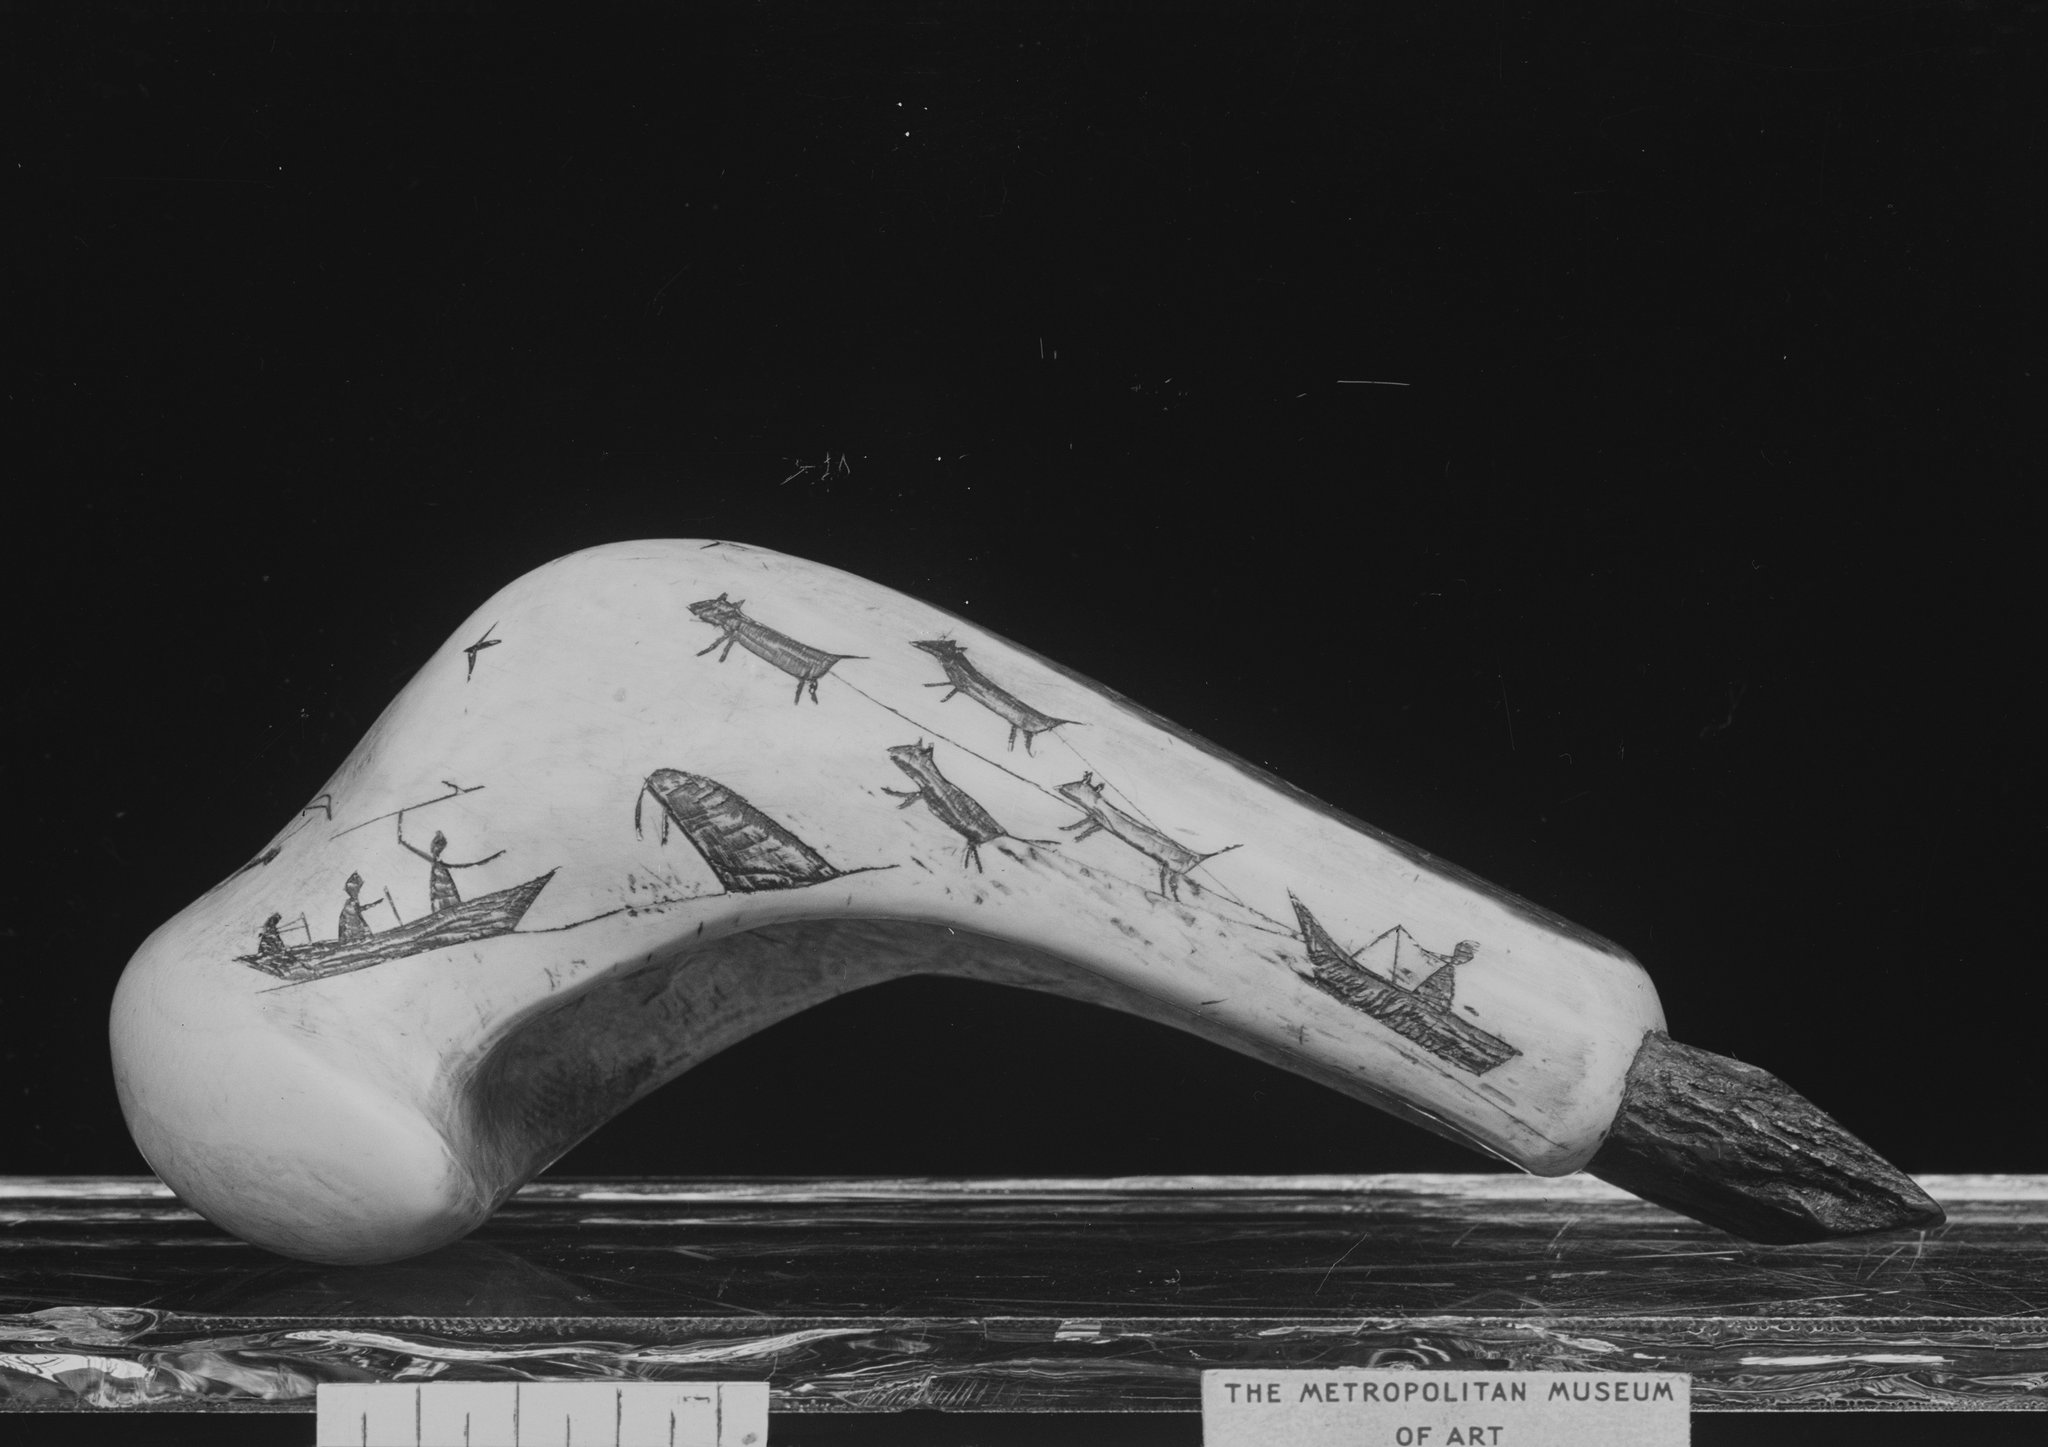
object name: scraper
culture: north american, alaskan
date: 1902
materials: jade